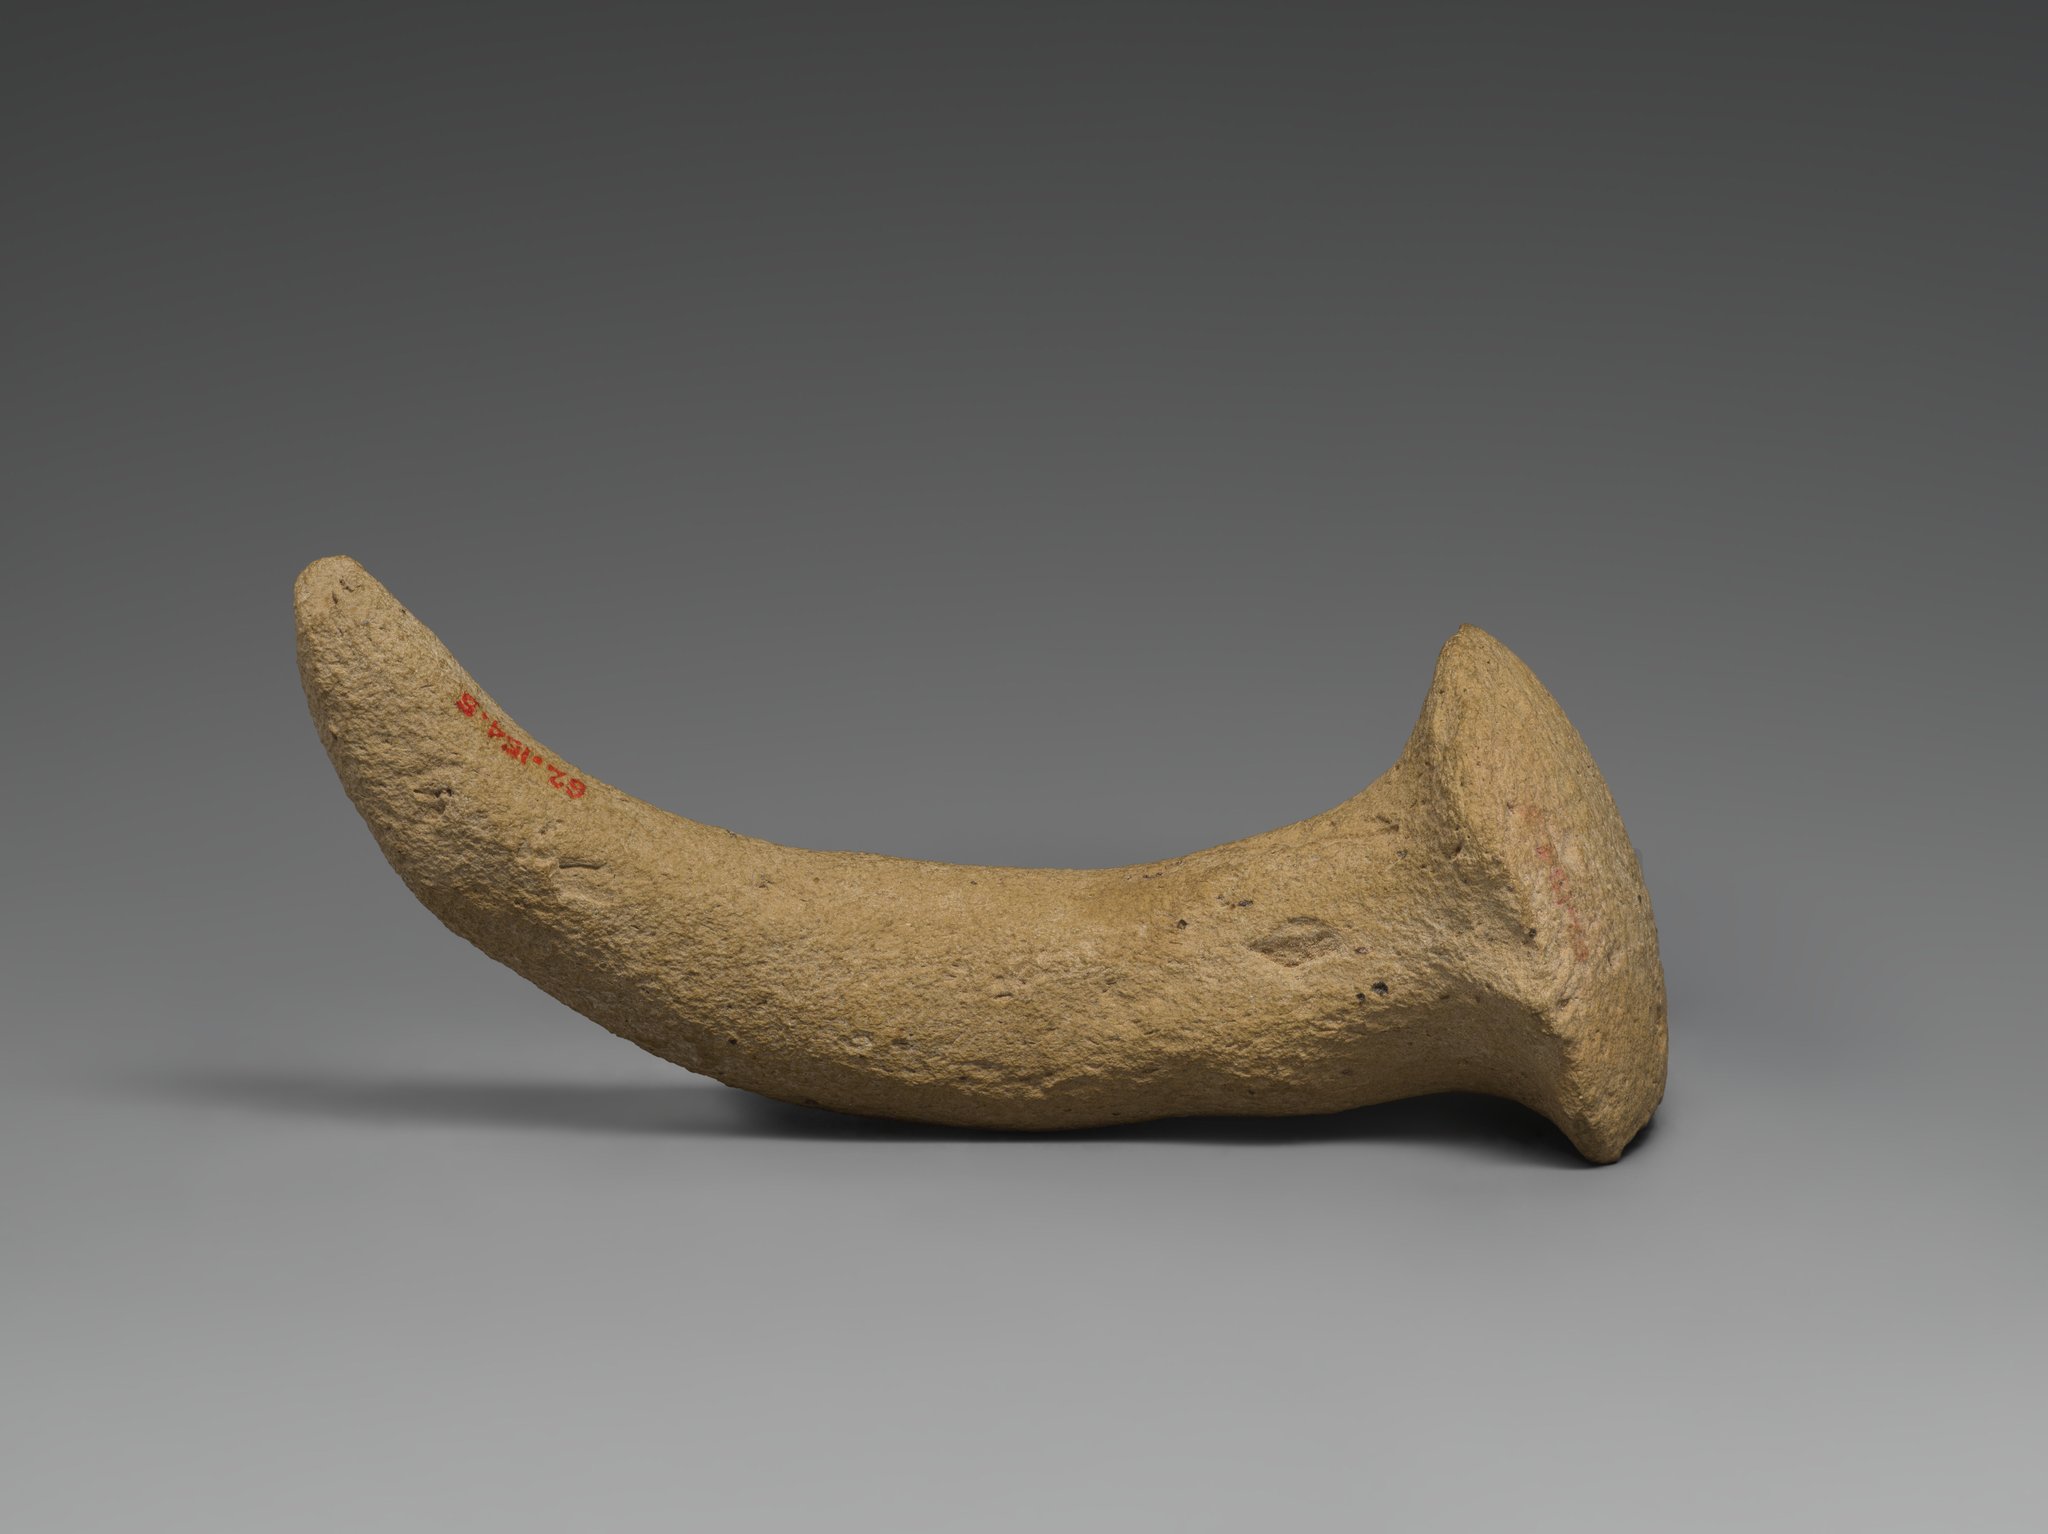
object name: pestle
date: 6000-3001 BCE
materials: ceramic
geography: mesopotamia